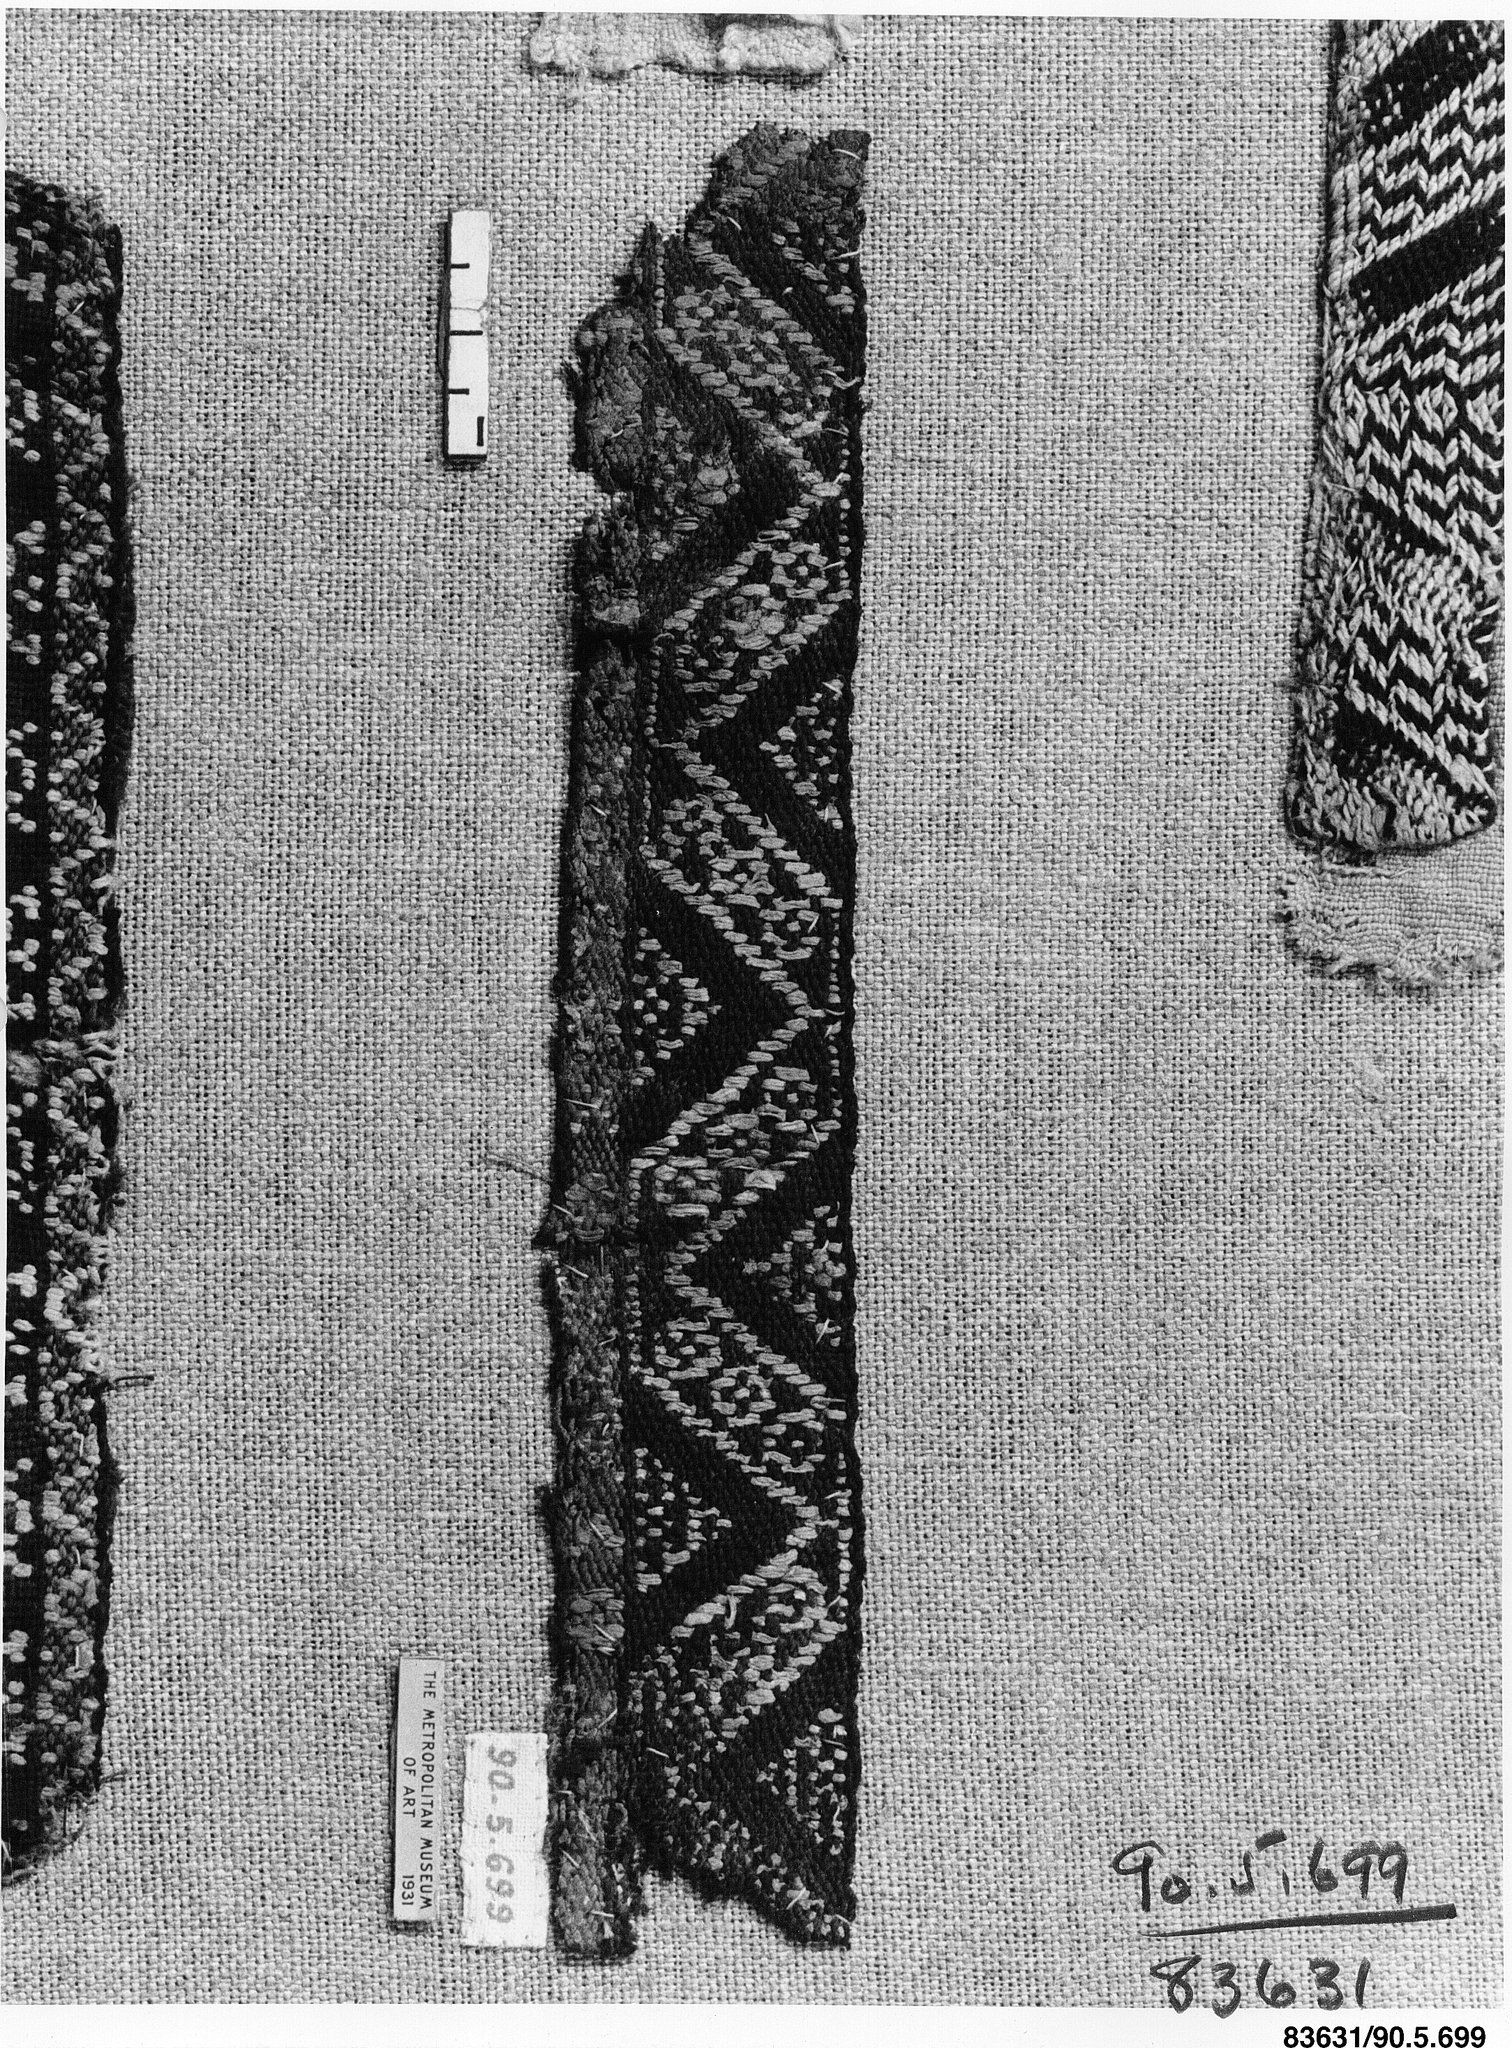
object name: textile fragment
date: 401-600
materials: linen, wool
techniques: weave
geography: egypt